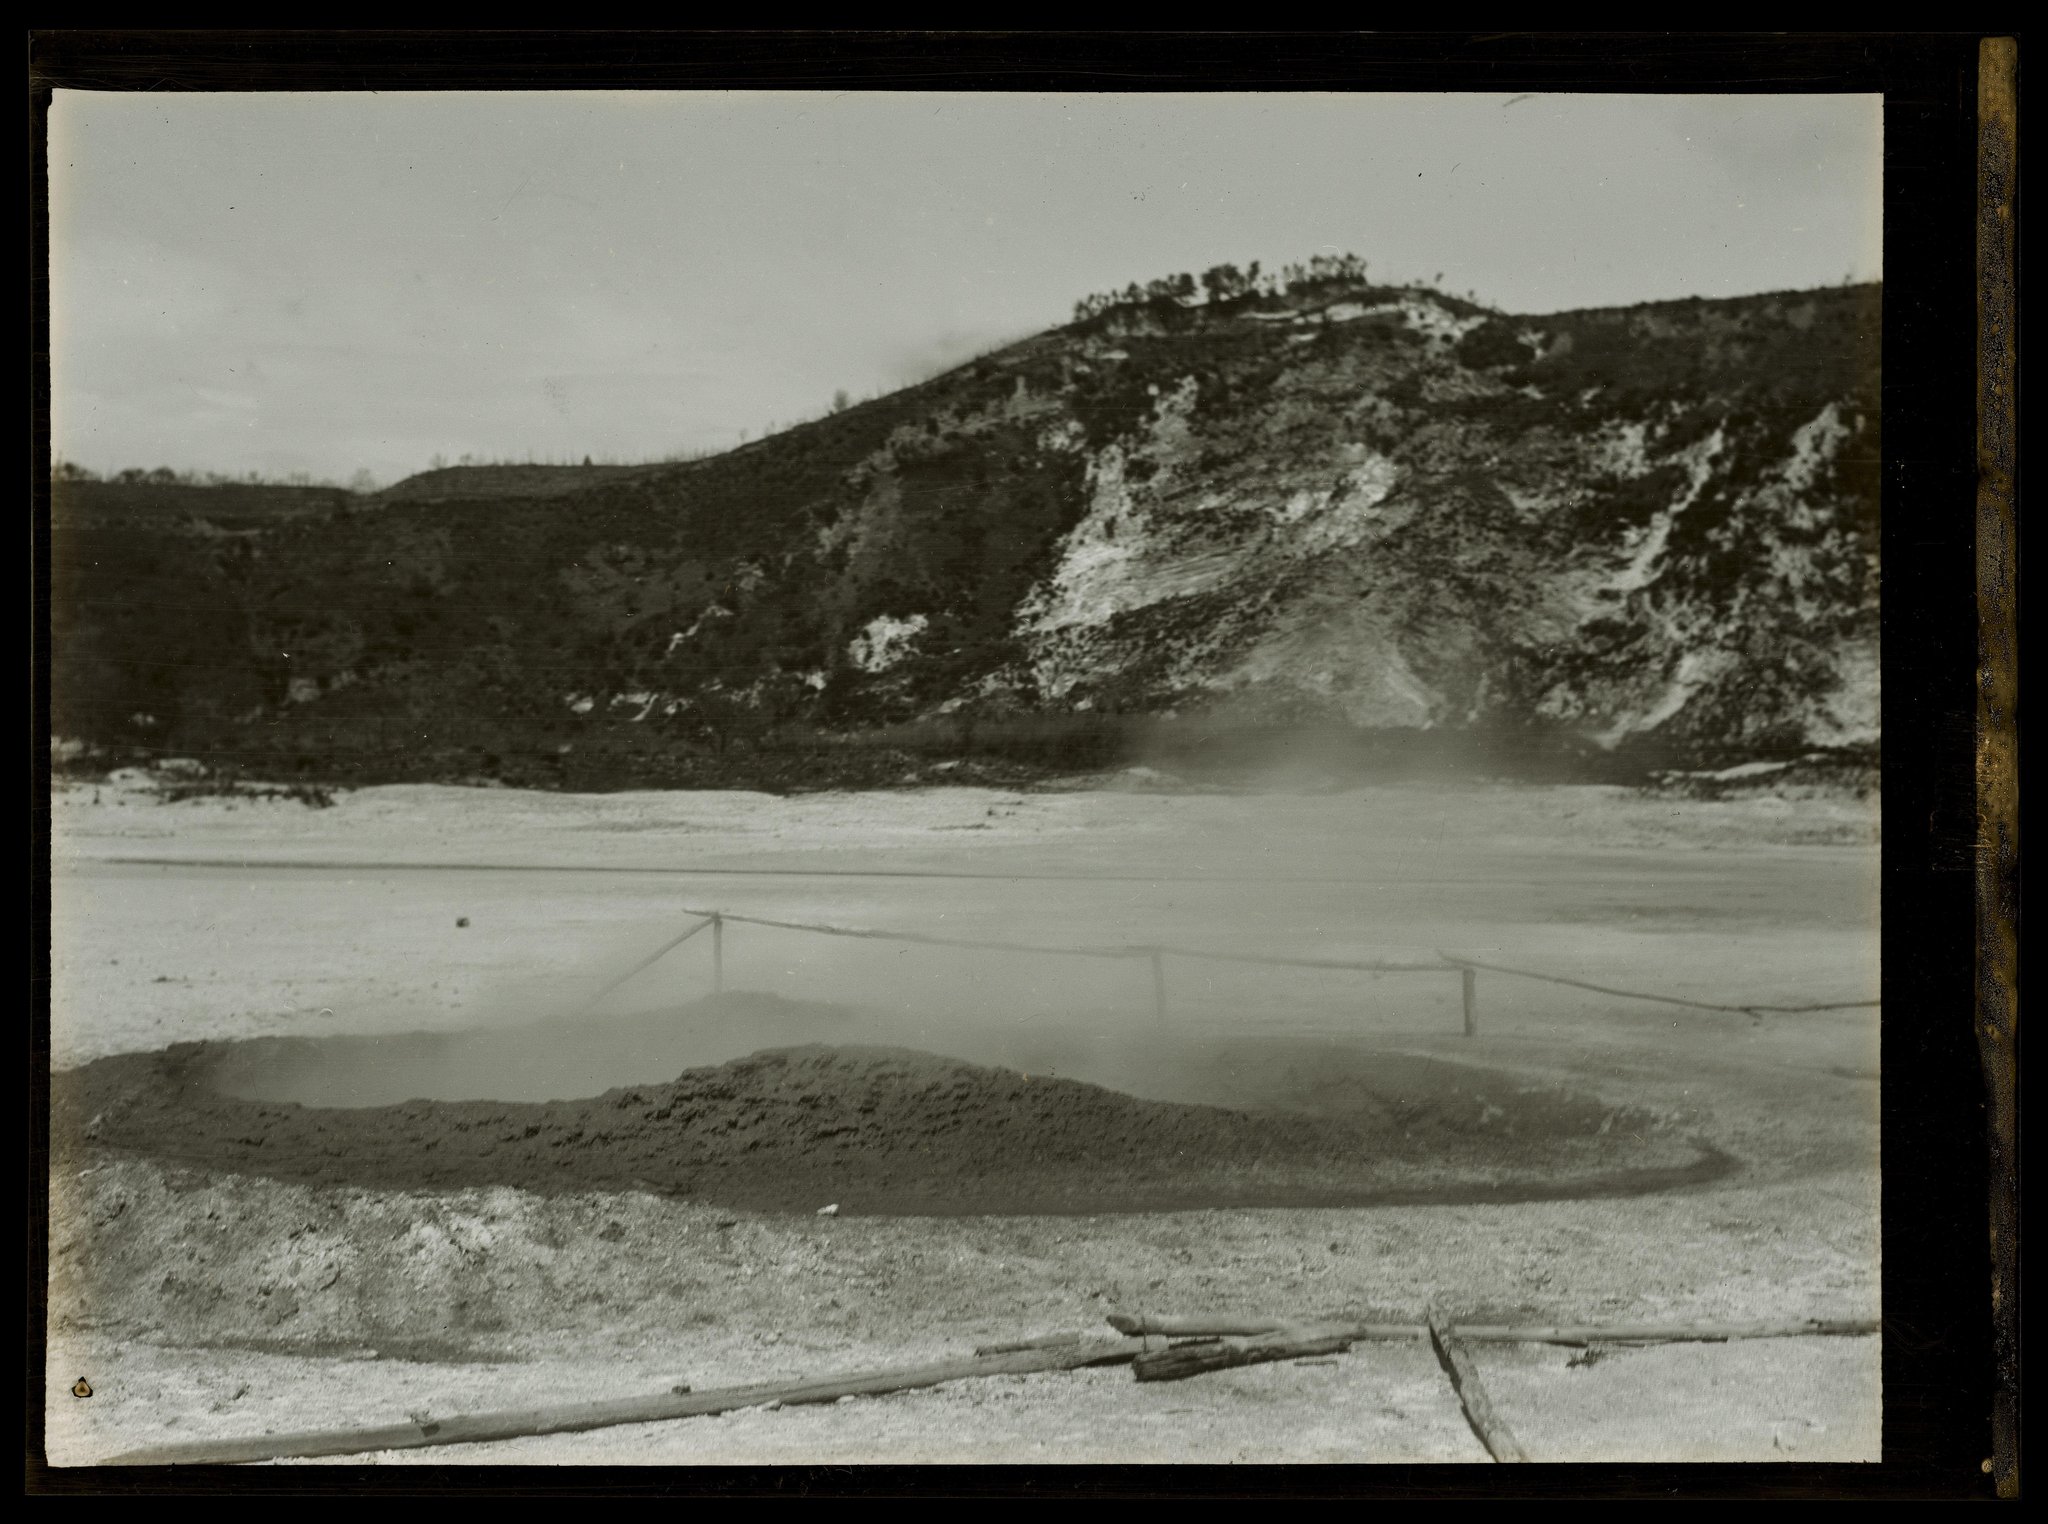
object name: negative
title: Filmnegatief met opname van Napels of omgeving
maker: Anonymous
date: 1907-1935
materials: film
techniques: gelatin silver negative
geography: italy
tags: italy